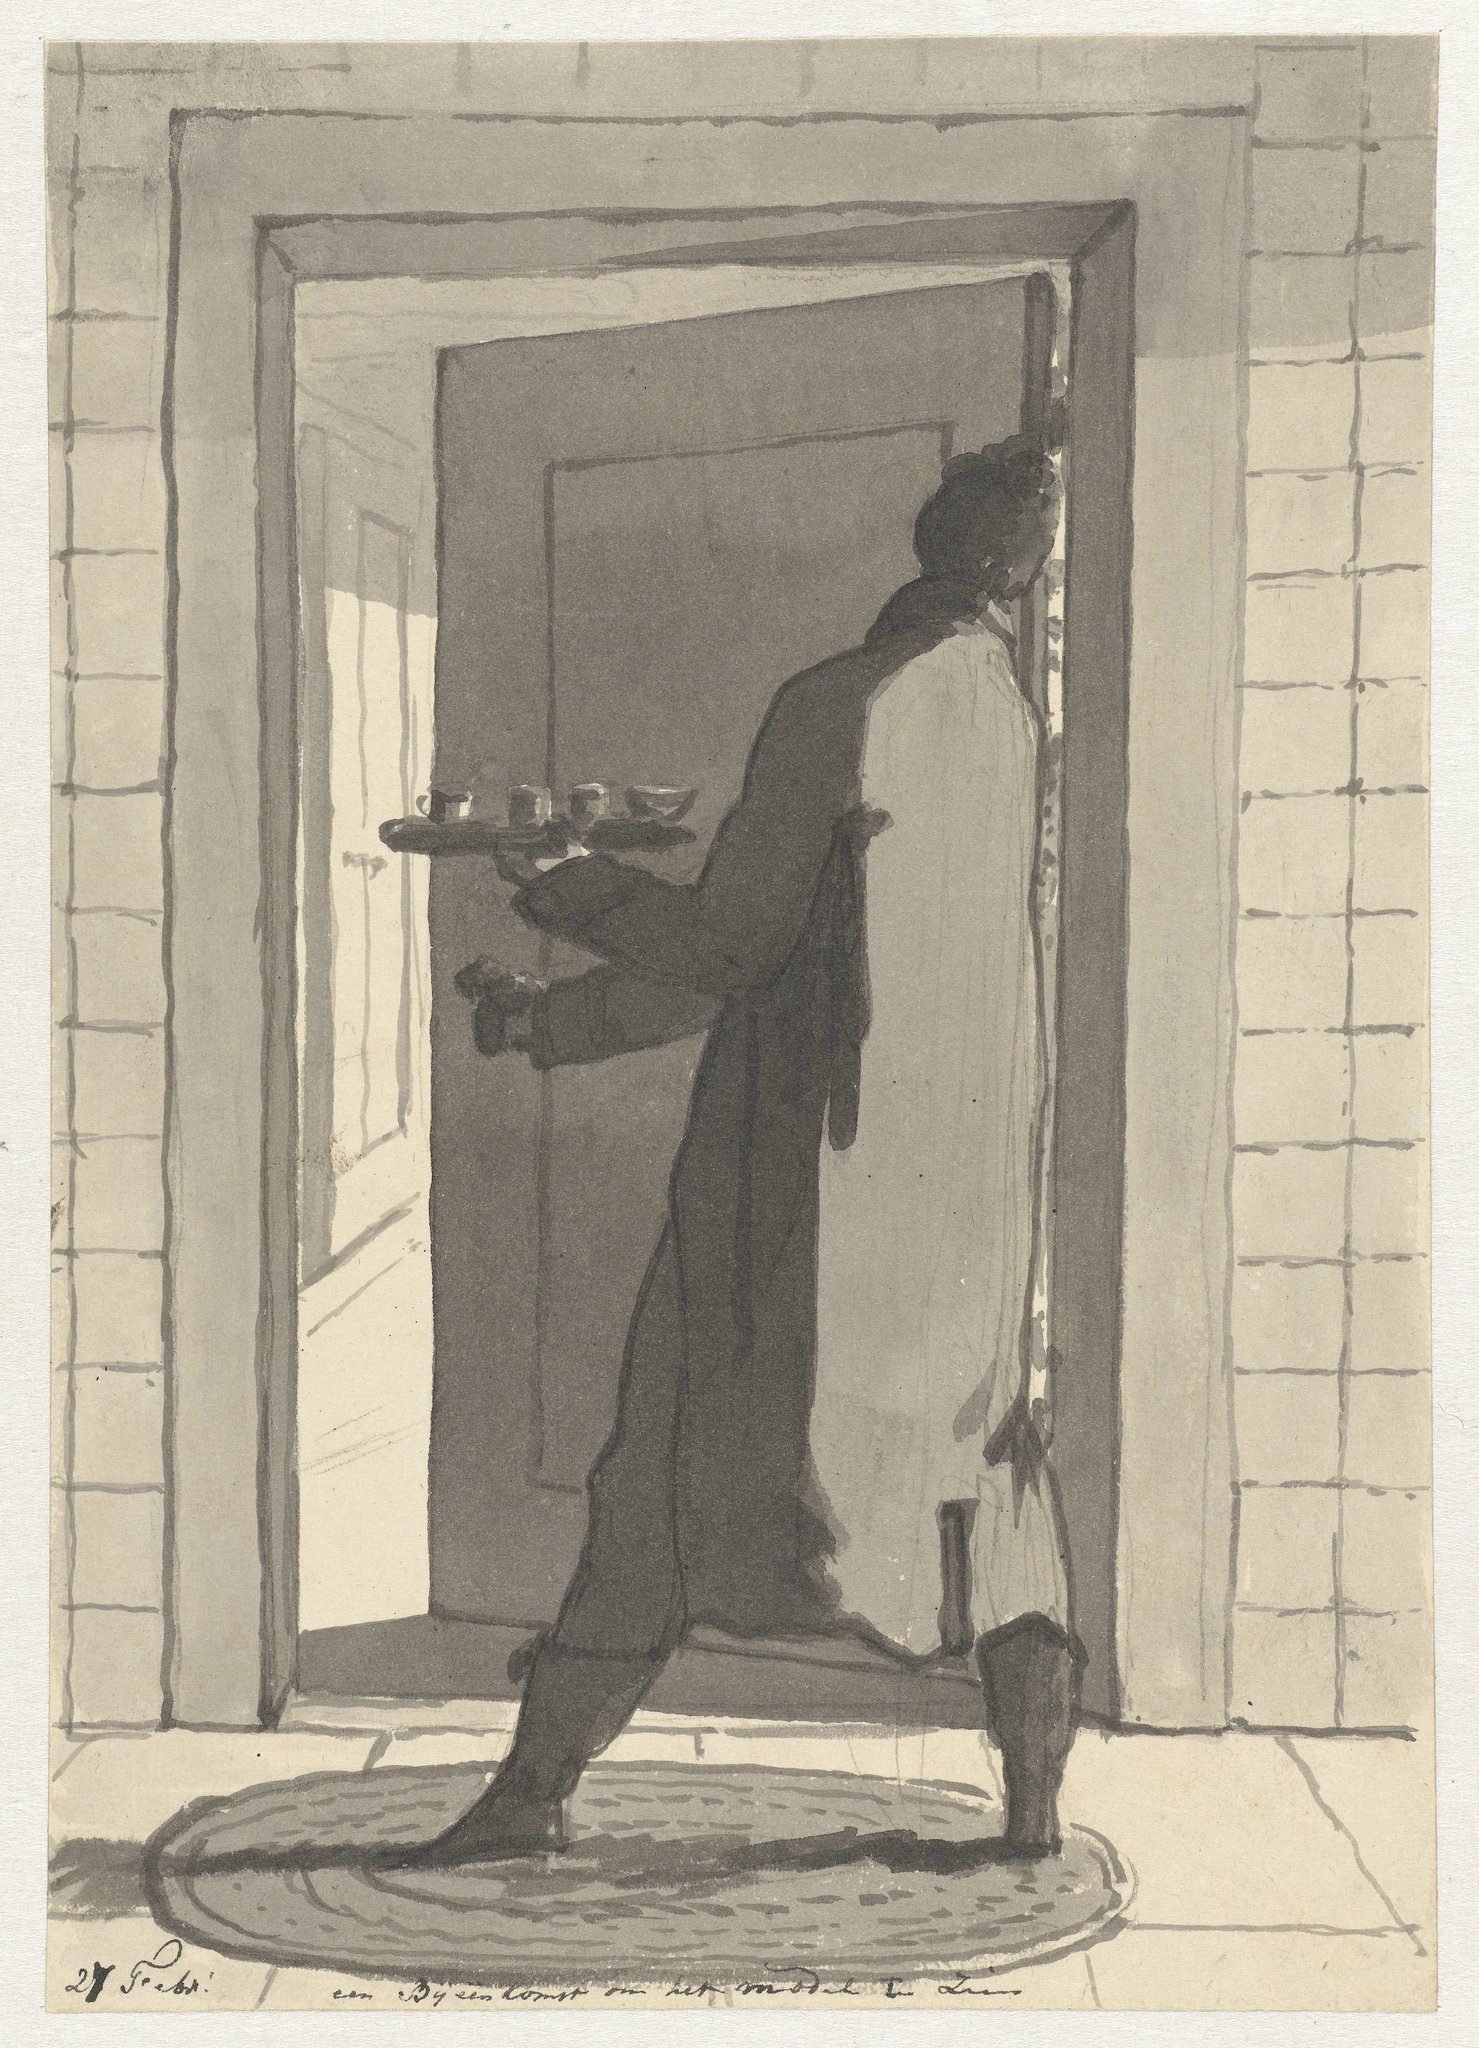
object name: drawing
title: ‘A Meeting to See the Model’ Christiaan Andriessen (1775-1846)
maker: christiaan andriessen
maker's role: draughtsman, print maker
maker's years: 1775-1846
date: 1805-1808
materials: paper, pencil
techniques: brush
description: This scene from Andriessen’s illustrated diary shows the artist standing in the hallway of his house that opens to the sitting room. Waiting inside is a young woman who has applied to work as a life model for a drawing session. Holding a tray with cups of tea in his left hand, and his right hand grasping the doorknob, Andriessen peers inside through a crack in the door, probably waiting for the right moment to enter.